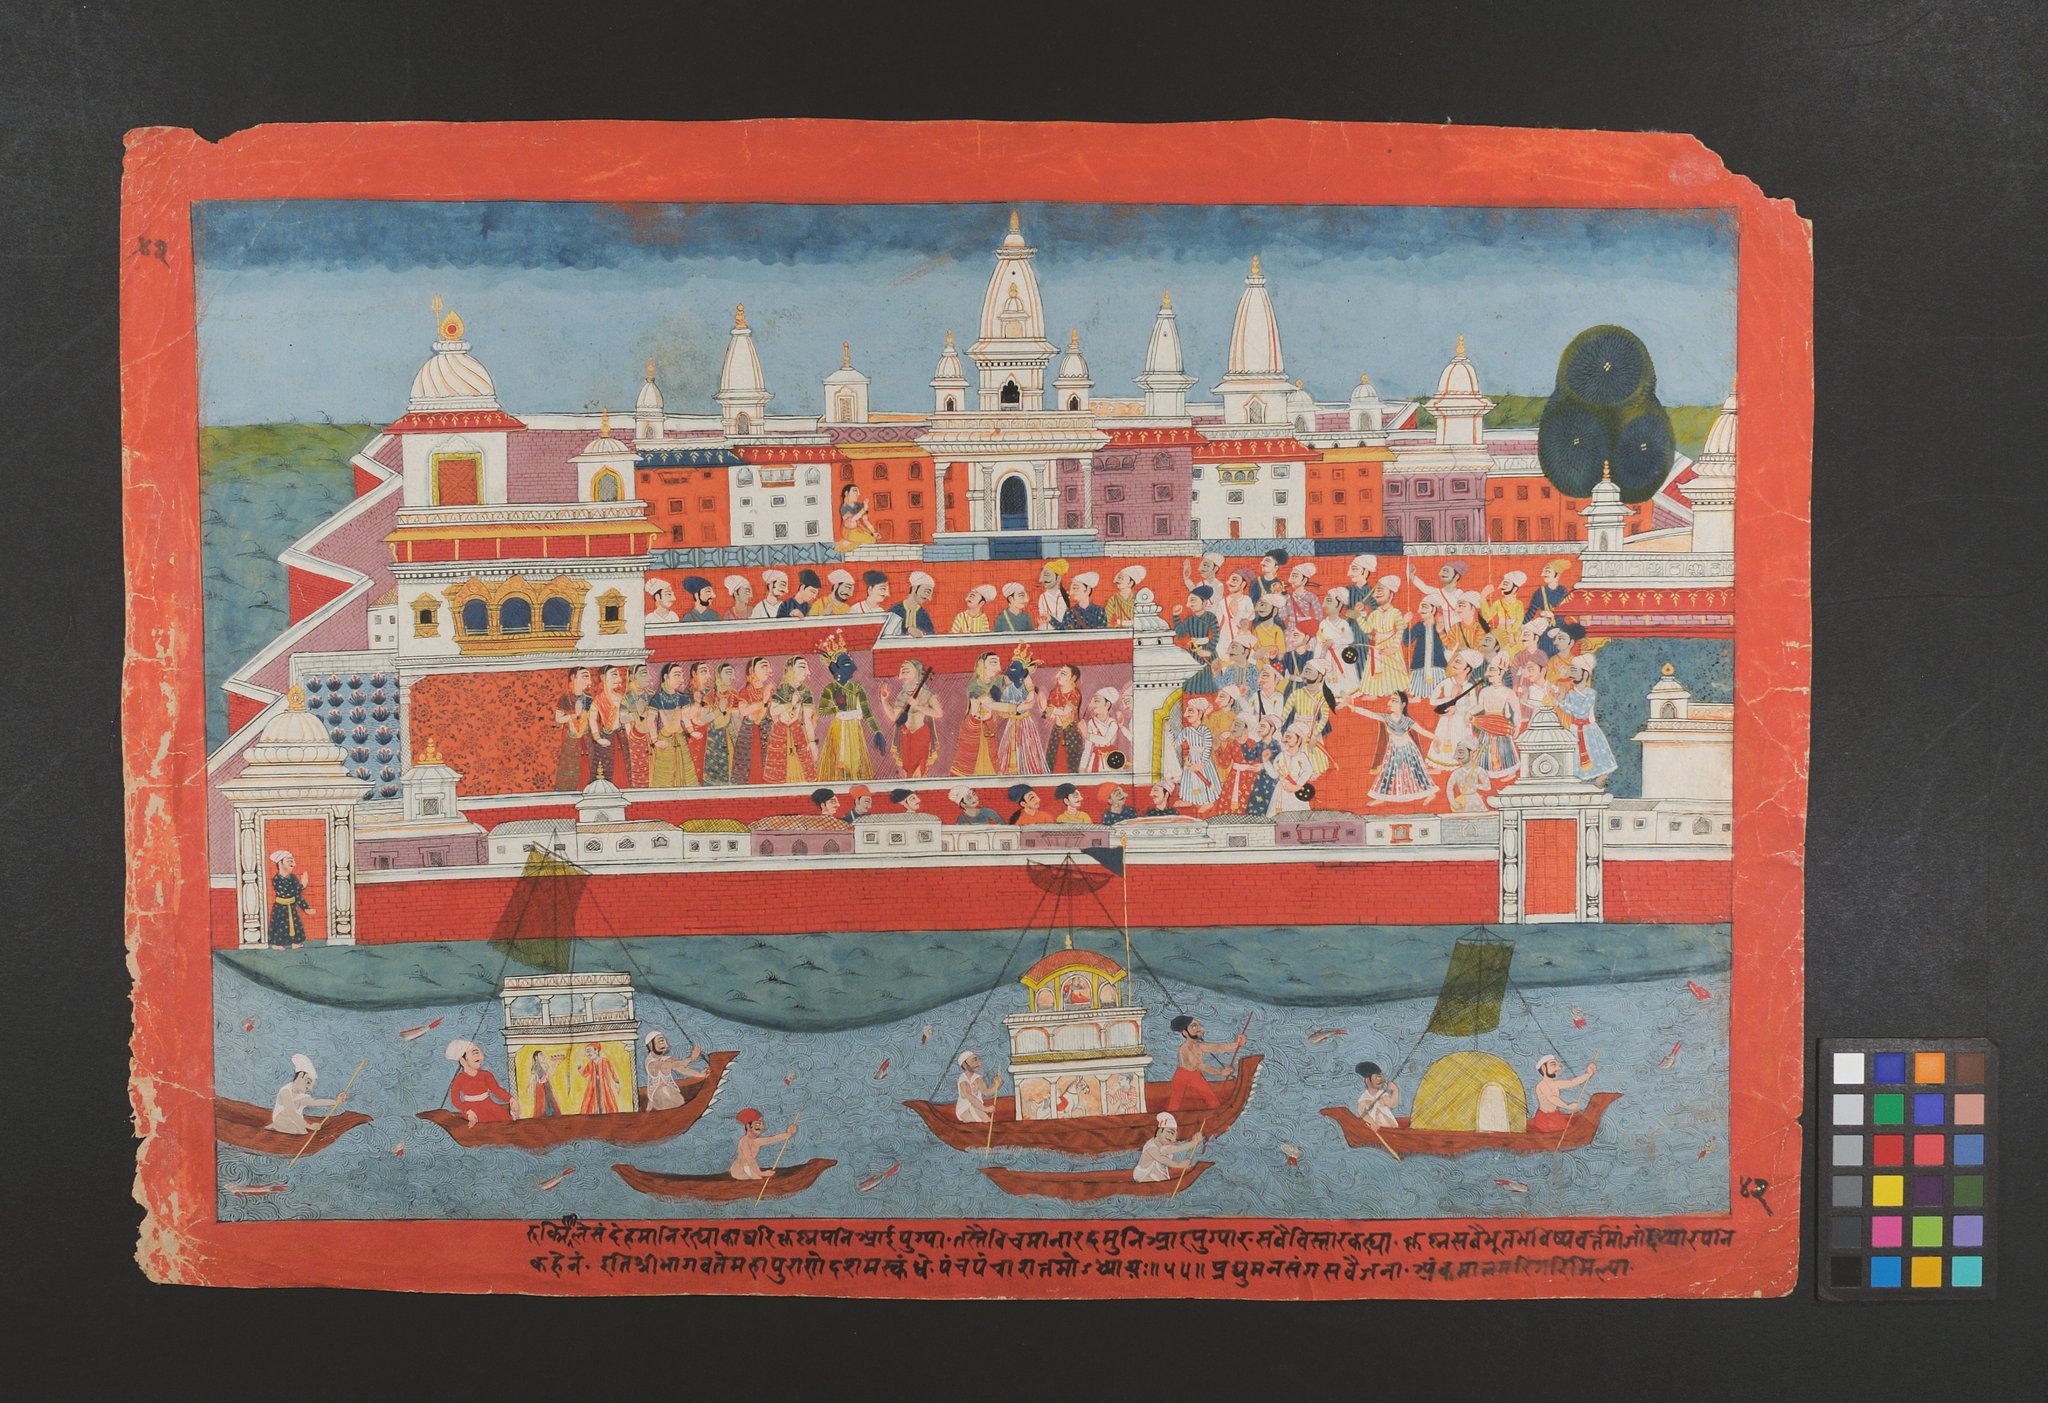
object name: folio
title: Page from a Dispersed Bhagavata Purana Manuscript (Life of Krishna)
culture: nepali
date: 1775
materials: ink, paper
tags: palaces,men,women,krishna,boats